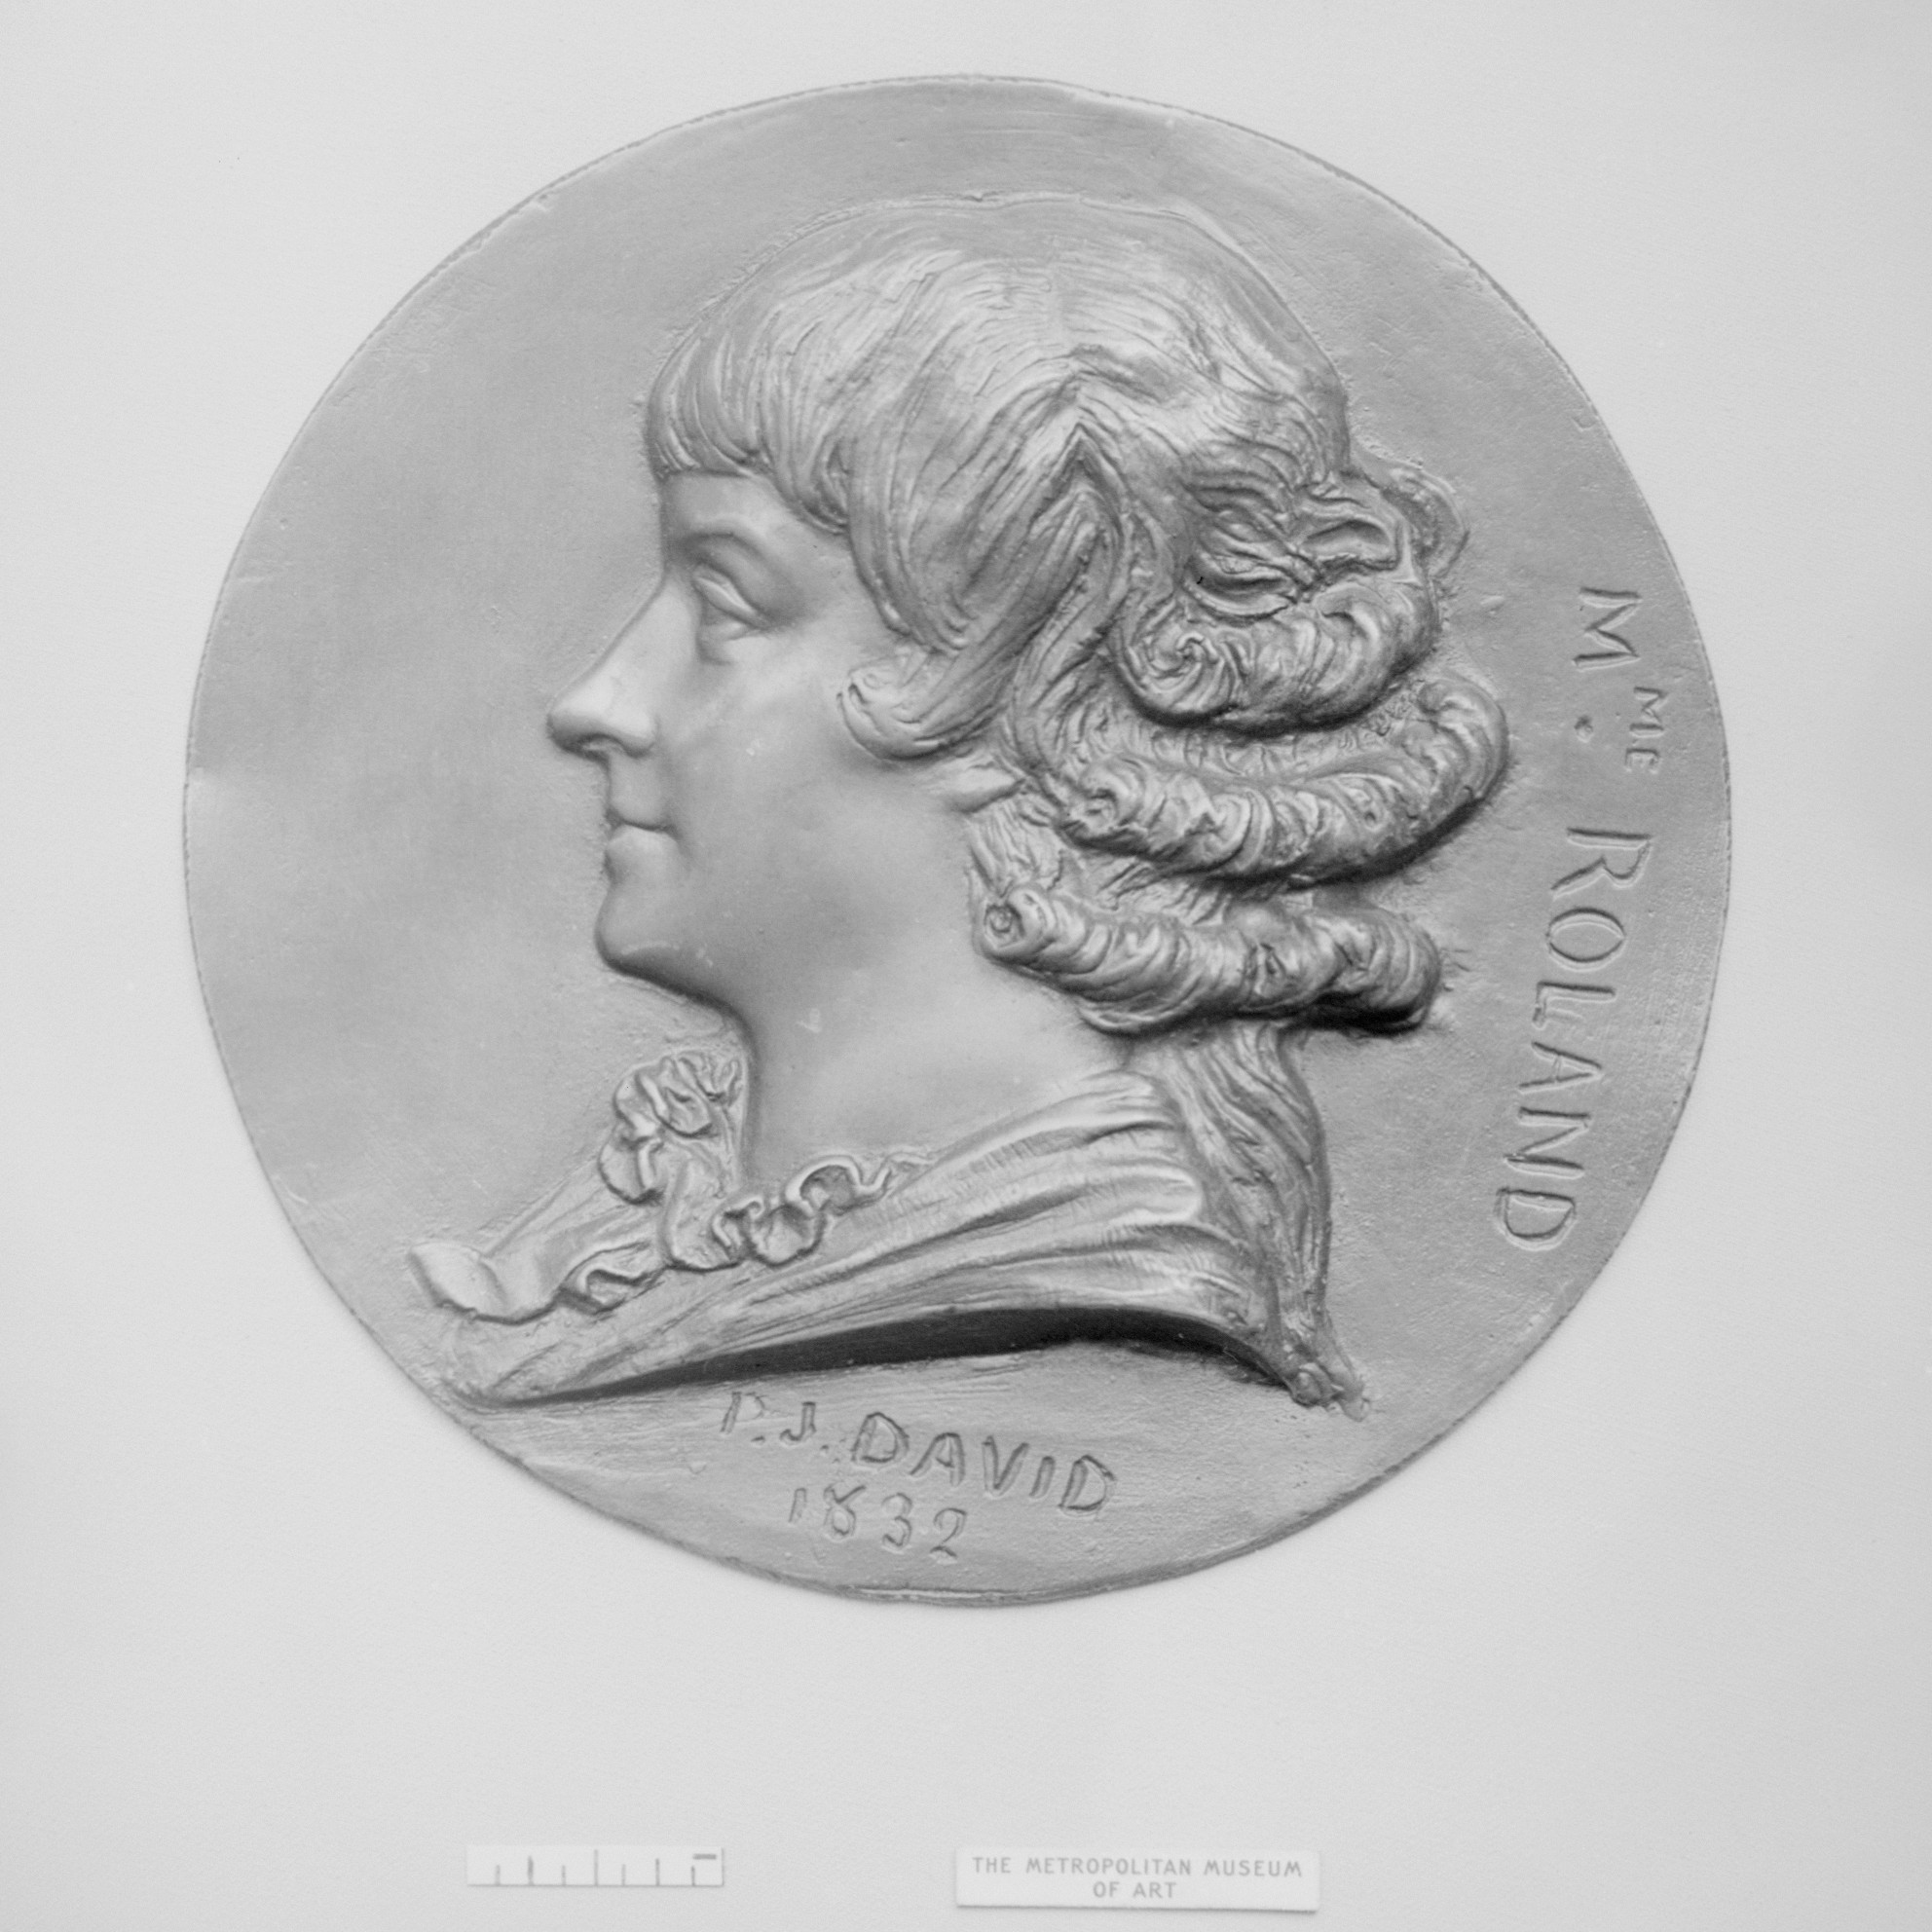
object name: medallion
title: Mme. Roland (Manon Jeanne Philipon) (1754–1793), French literary woman and politician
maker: pierre jean david d'angers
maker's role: artist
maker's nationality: french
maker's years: 1788-1856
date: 1801-1900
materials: bronze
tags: profiles,women